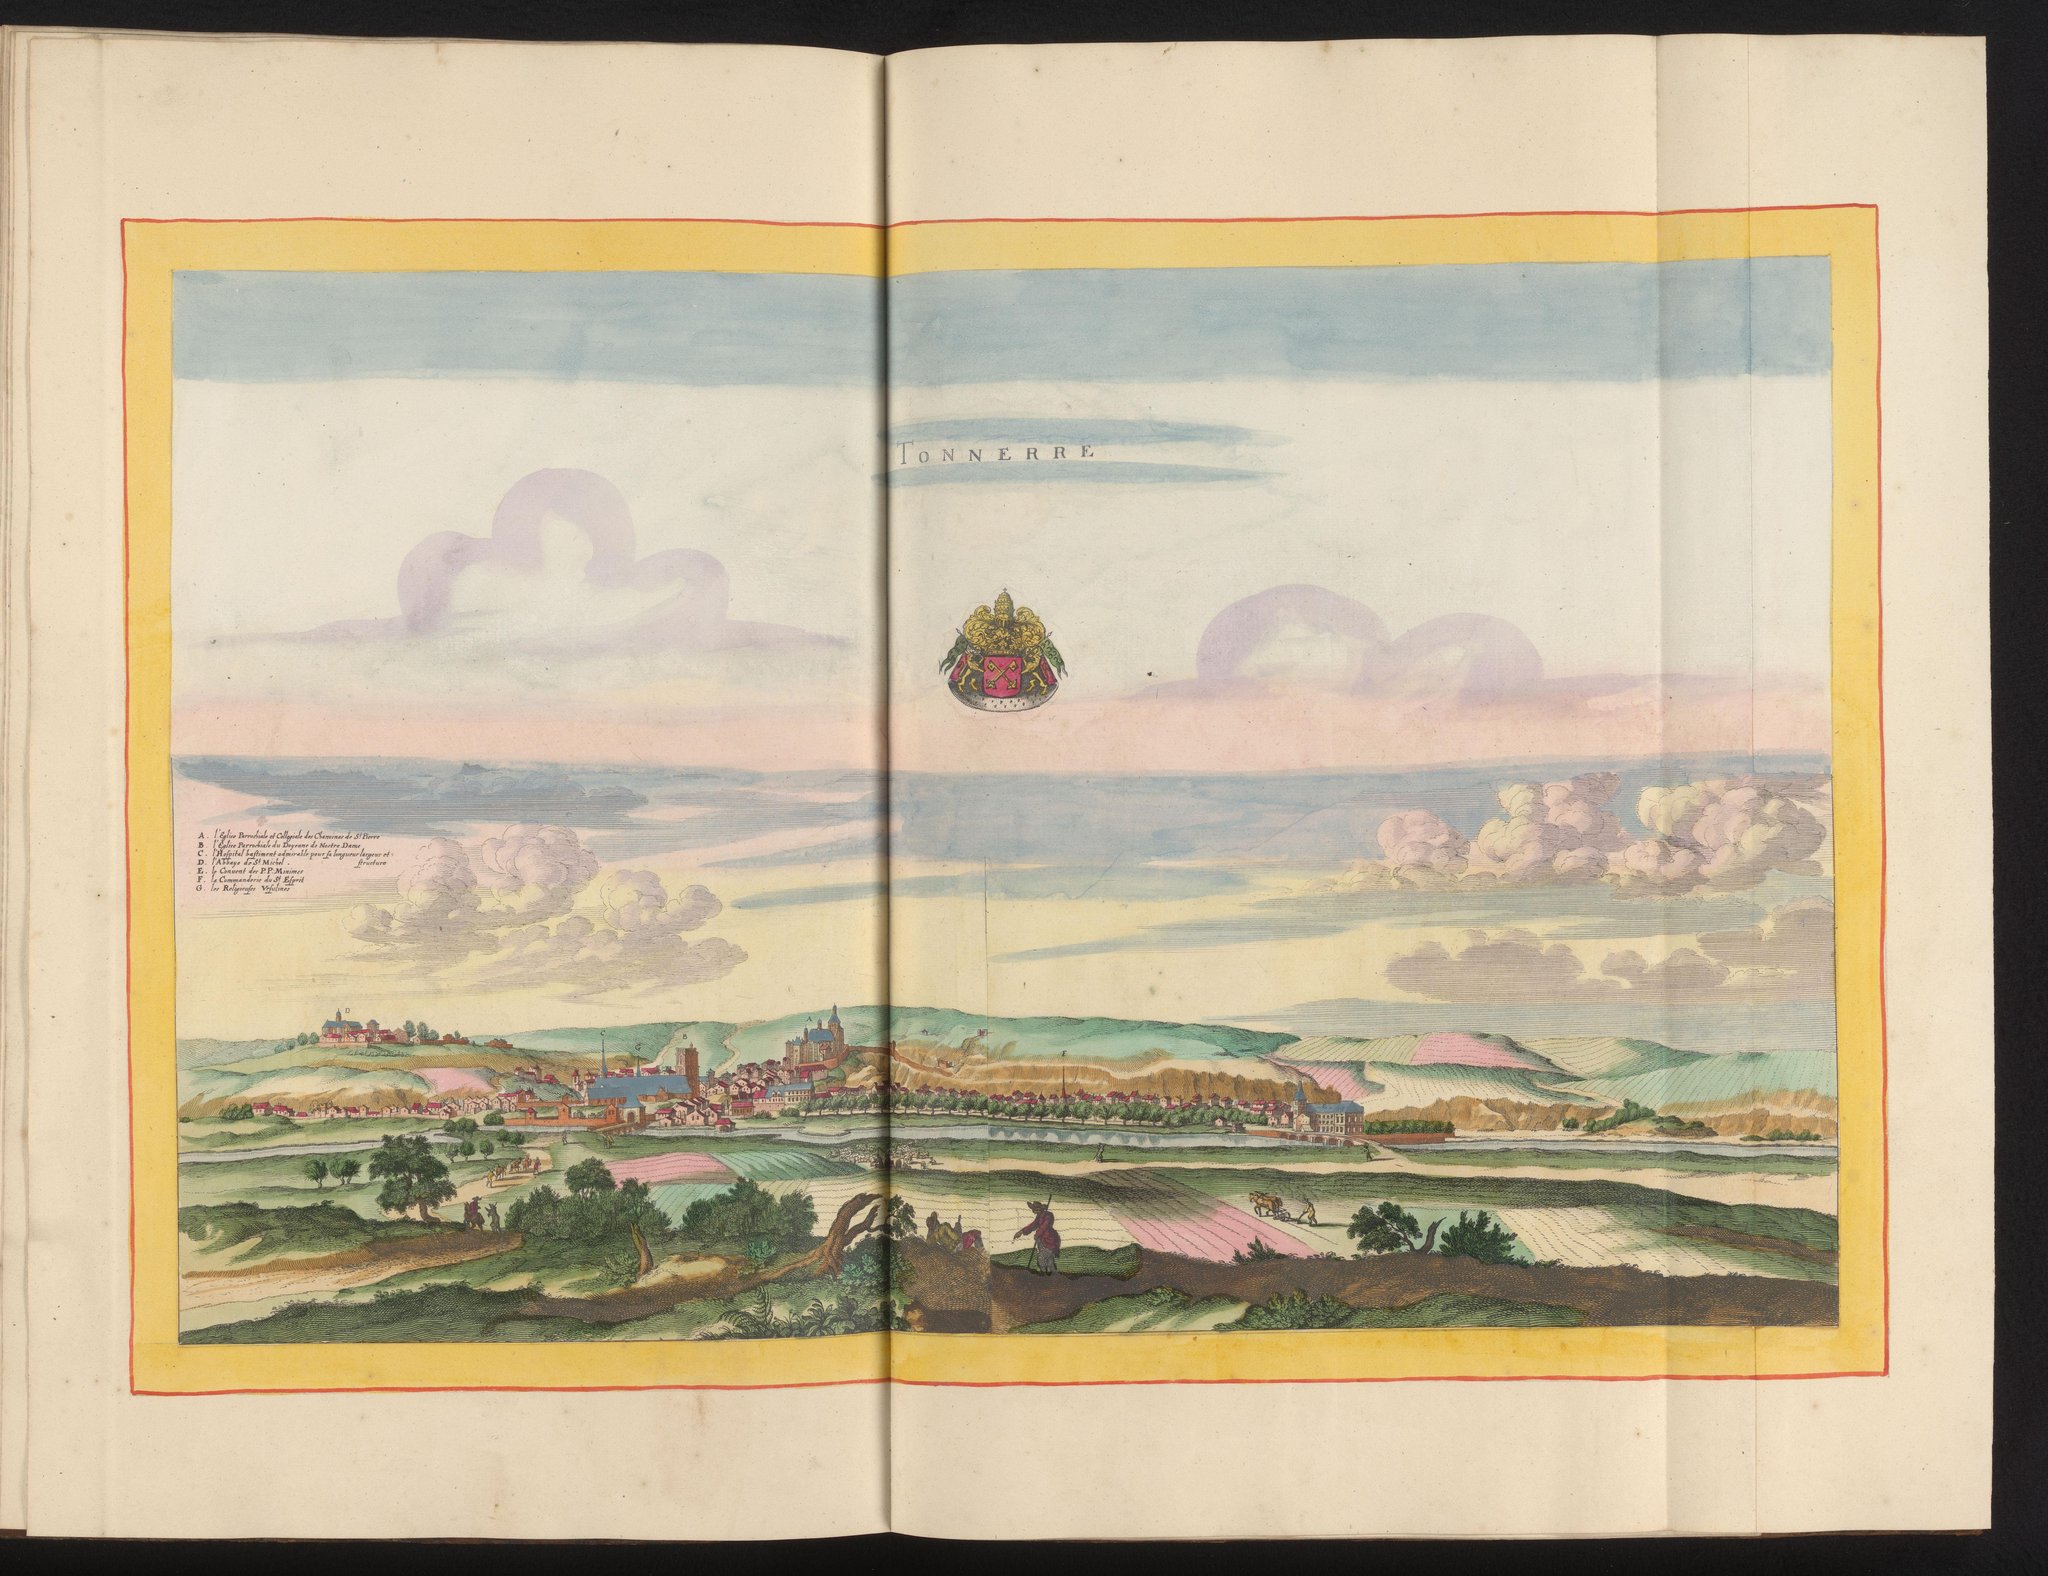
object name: print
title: Tonnerre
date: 1656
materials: paper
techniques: engraving, etching, hand coloring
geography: frankfurt am main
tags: city-view in general; 'veduta'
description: Prent uit: Zeiller, Martin. Topographia Galliae. 13 dln. Frankfurt: Caspar Merian, 1656, dl. 3, na p. 32.